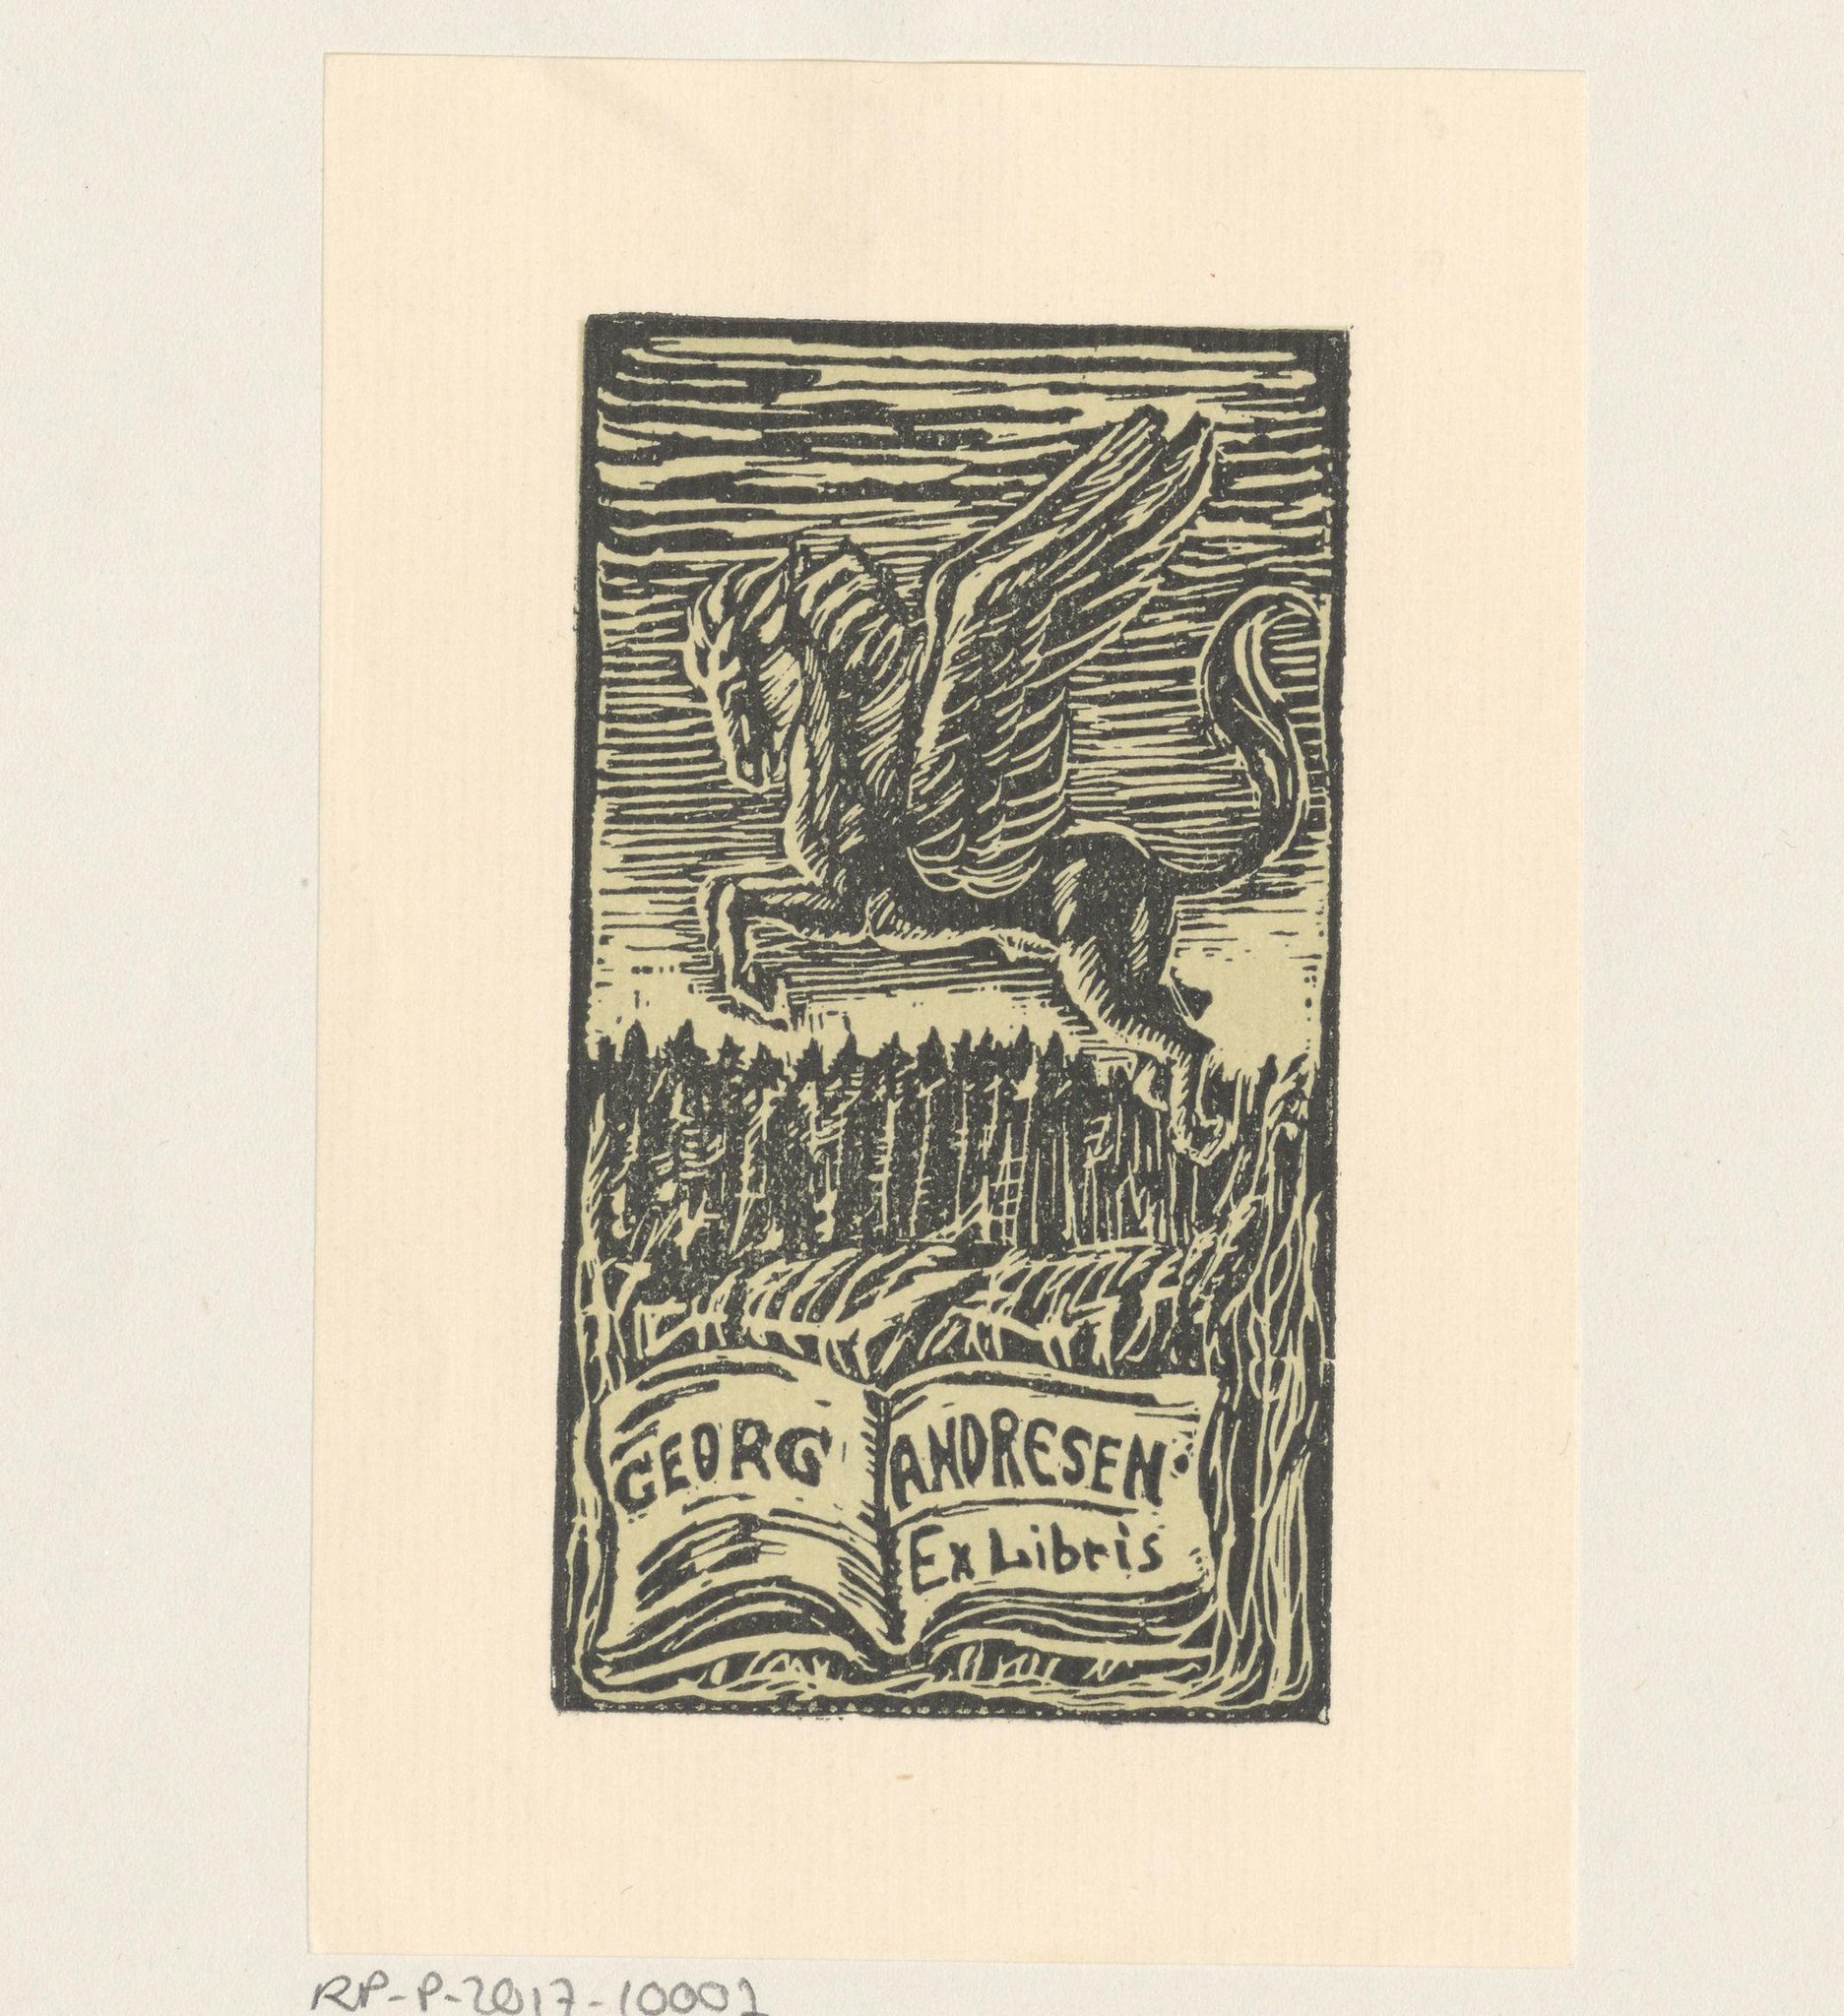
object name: bookplate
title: Ex libris van Georg Andresen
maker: poul egebæk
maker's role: print maker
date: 1954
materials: paper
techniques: linocut, planographic printing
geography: denmark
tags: birds, saving a person from drowning, man (showing himself) undressed, quasi-nude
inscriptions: workshop stamp: ‘Fecit: Poul Egebaek/ Rudkøbing/ Danmark’